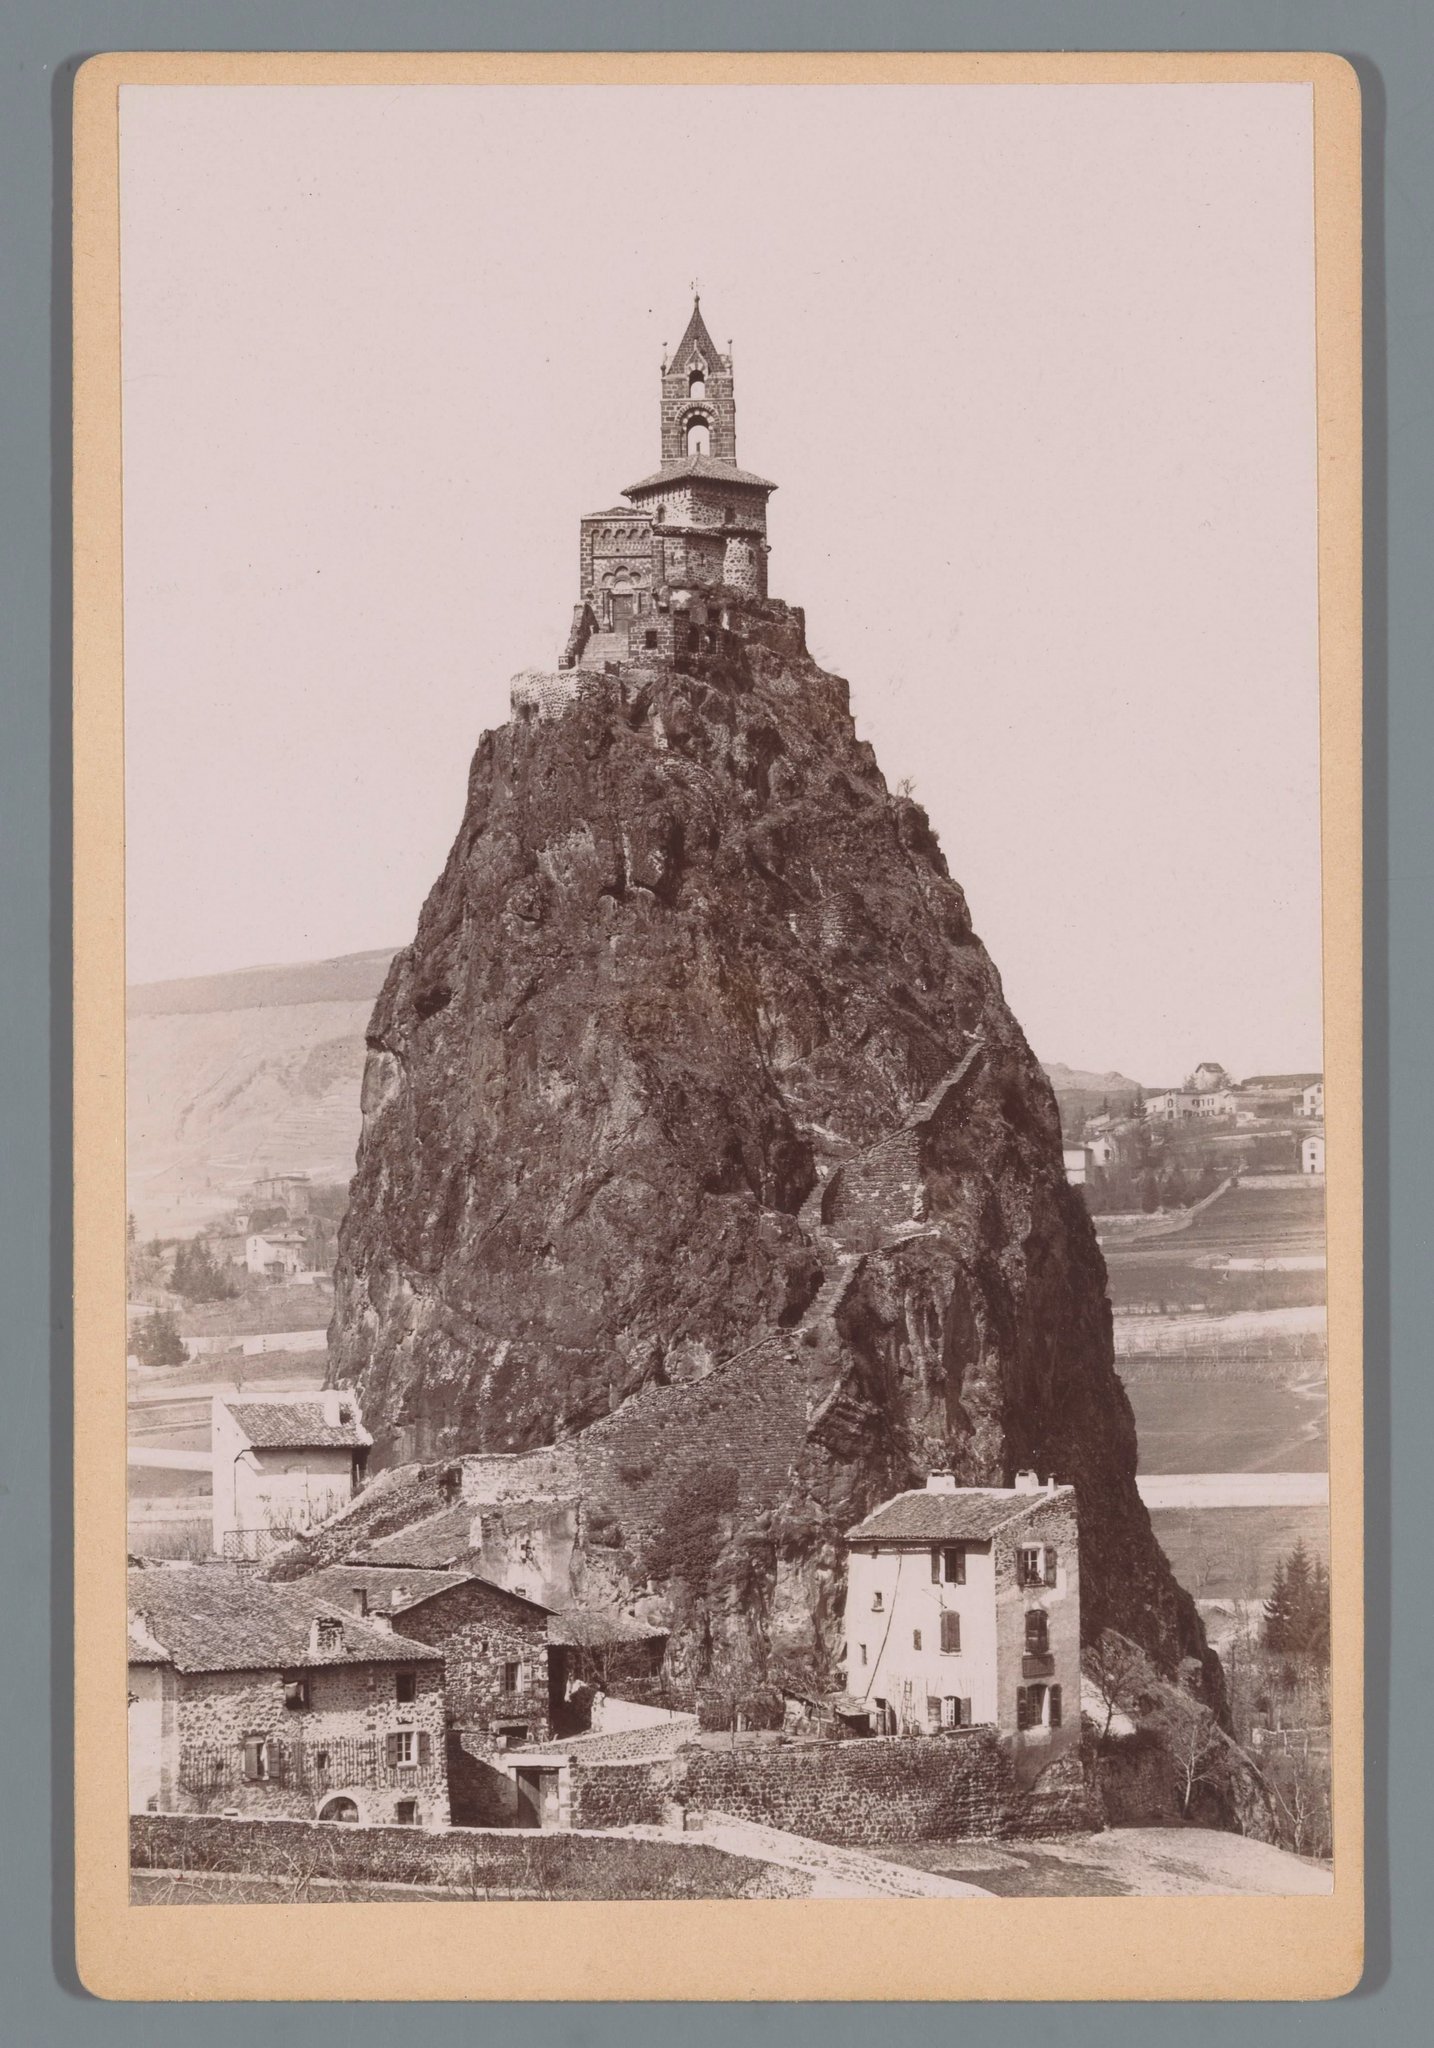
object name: photograph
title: Gezicht op de Saint-Michel d'Aiguilhe in Le Puy-en-Velay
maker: Anonymous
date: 1880-1945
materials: cardboard, photographic support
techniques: gelatin silver print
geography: le puy-en-velay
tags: parts of church exterior and annexes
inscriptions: annotation: ‘Le Puy/ [...] l'aiguilhe [...]’